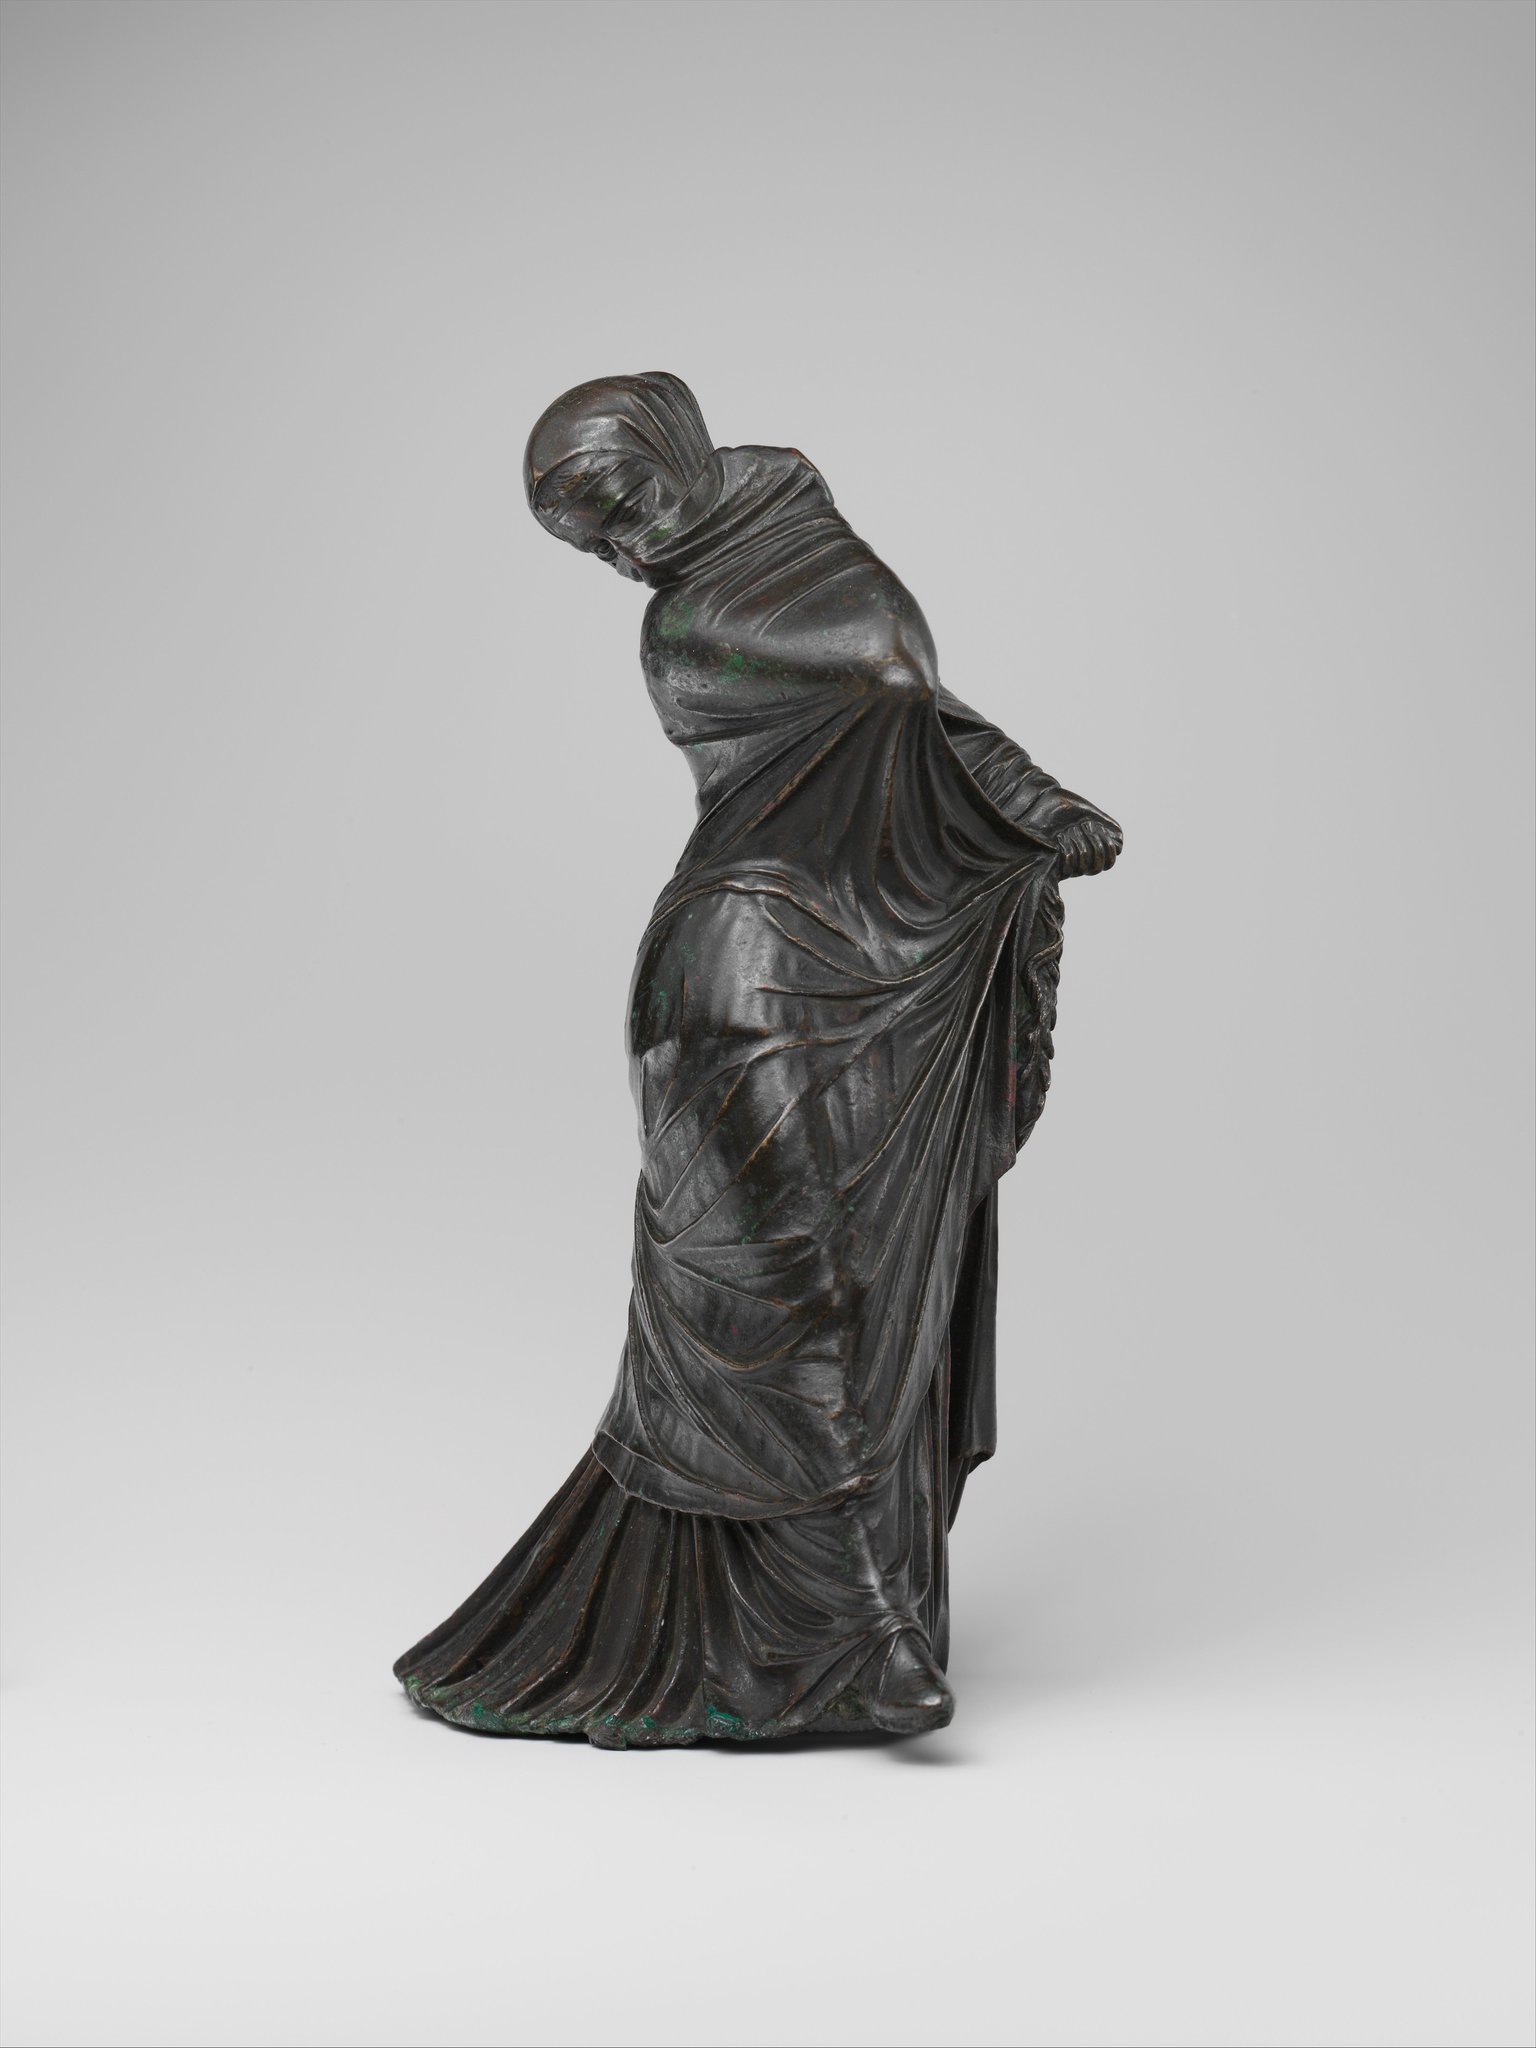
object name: statuette of a veiled and masked dancer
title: Bronze statuette of a veiled and masked dancer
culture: greek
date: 300-101 BCE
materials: bronze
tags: women,dancers